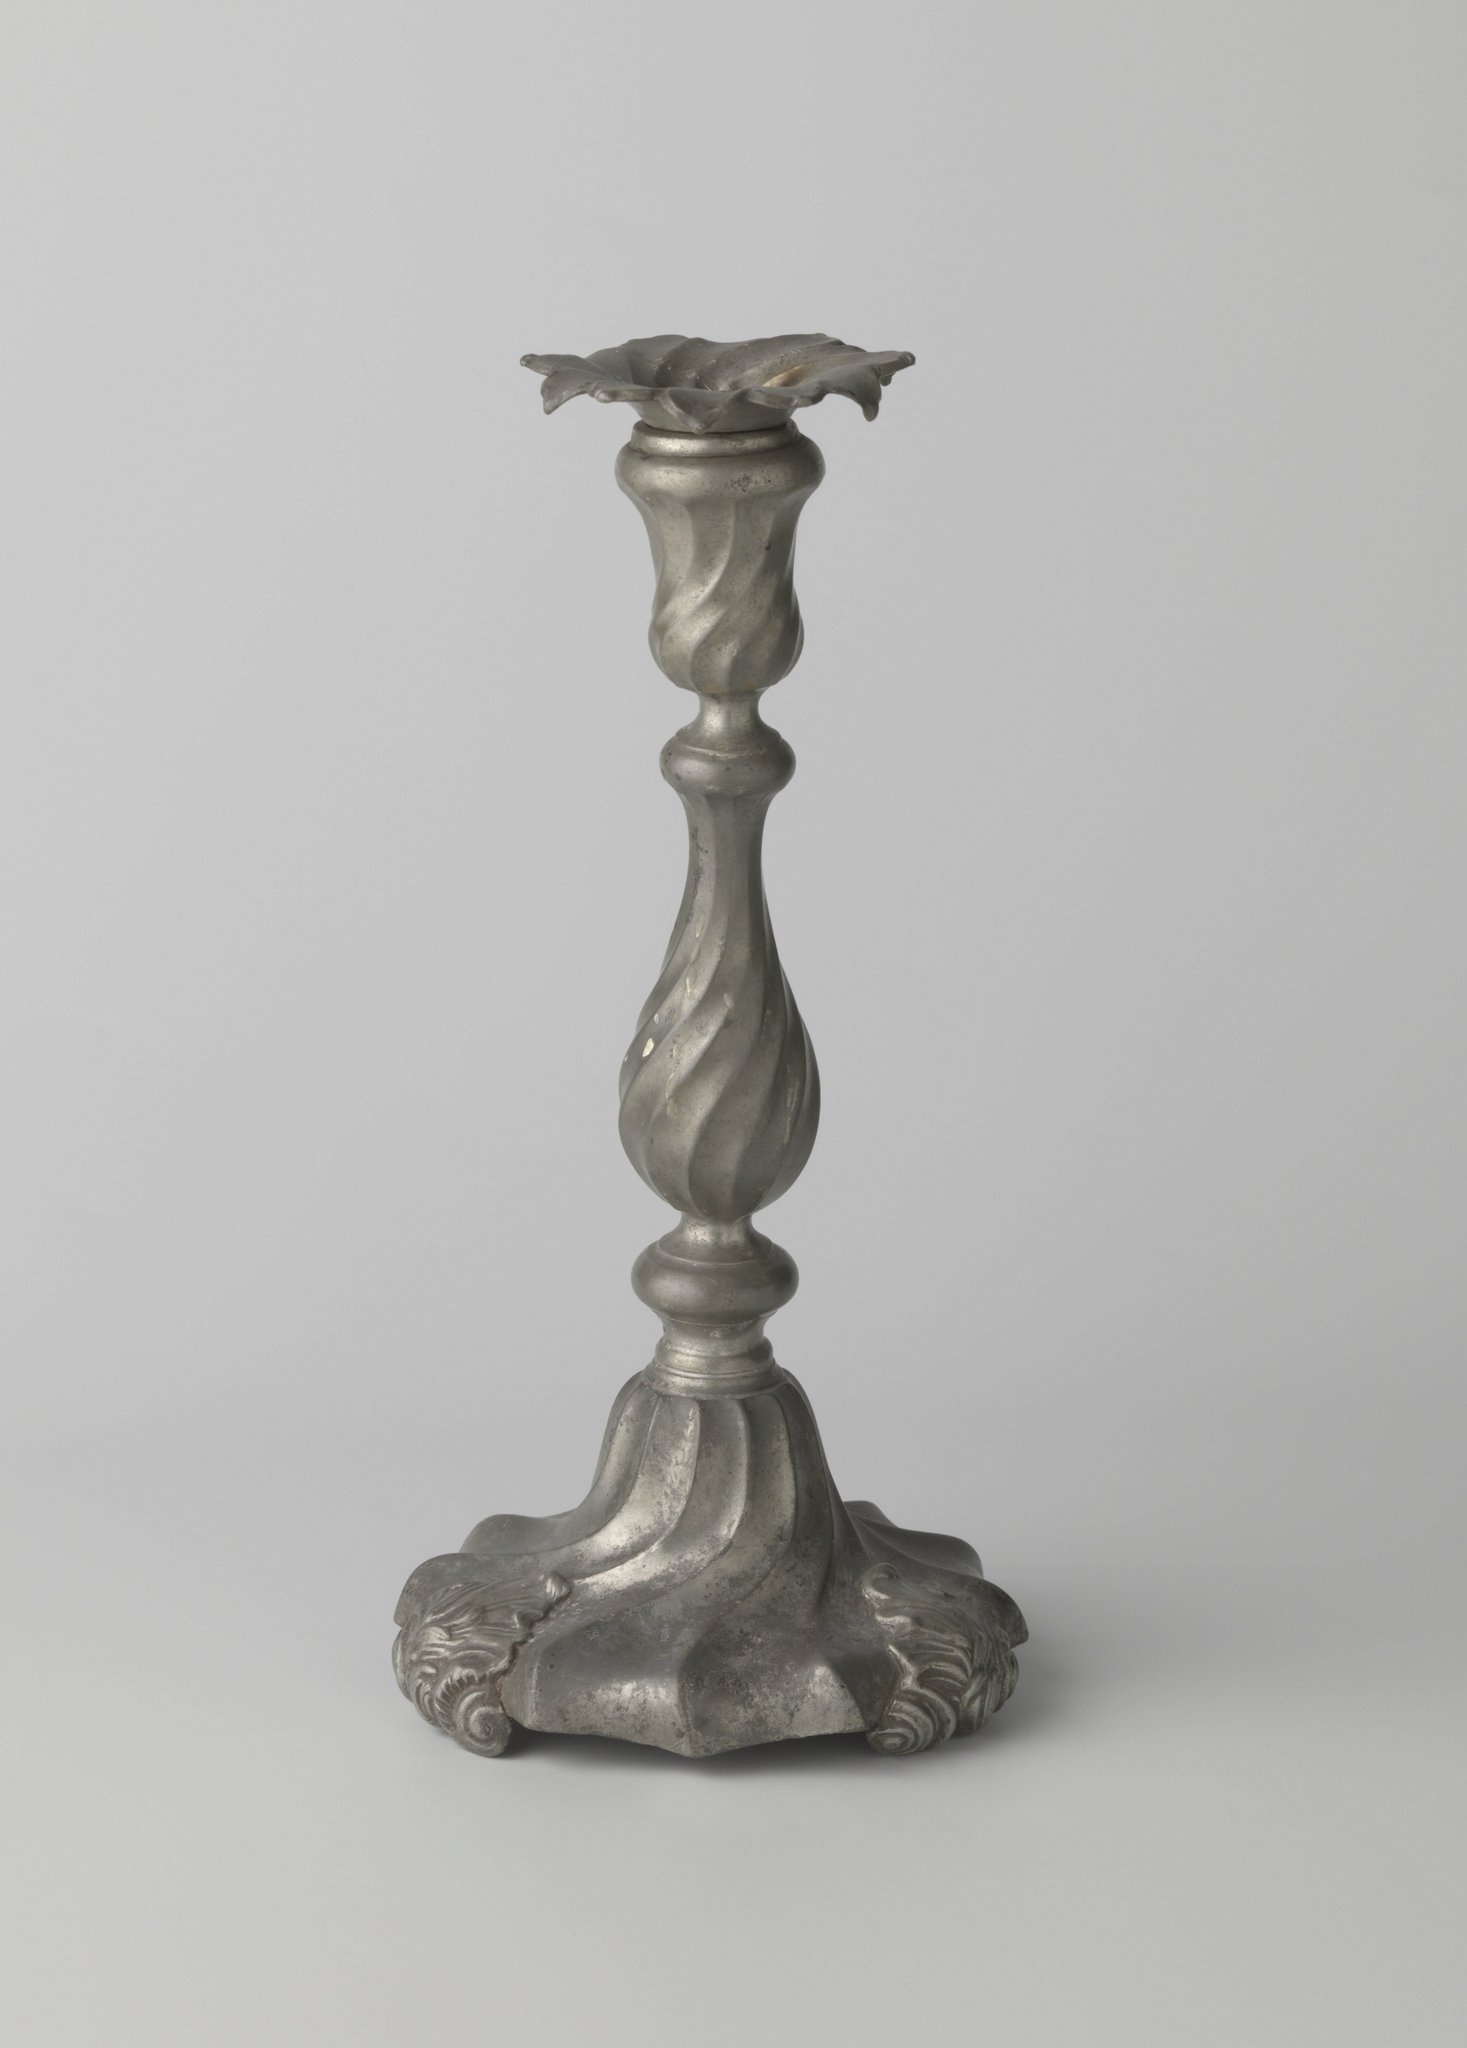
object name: candlestick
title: Kandelaar van tin, getordeerd model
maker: Anonymous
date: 1700-1800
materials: tin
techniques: casting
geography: netherlands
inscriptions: quality mark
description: Kandelaar van tin. De getordeerde voet staat op drie lage poten, gevormd door voluten. De balustervormige stam is getordeerd met een daarboven een bokaalvorm, waarop de bloemvormige vetvanger is aangebracht.